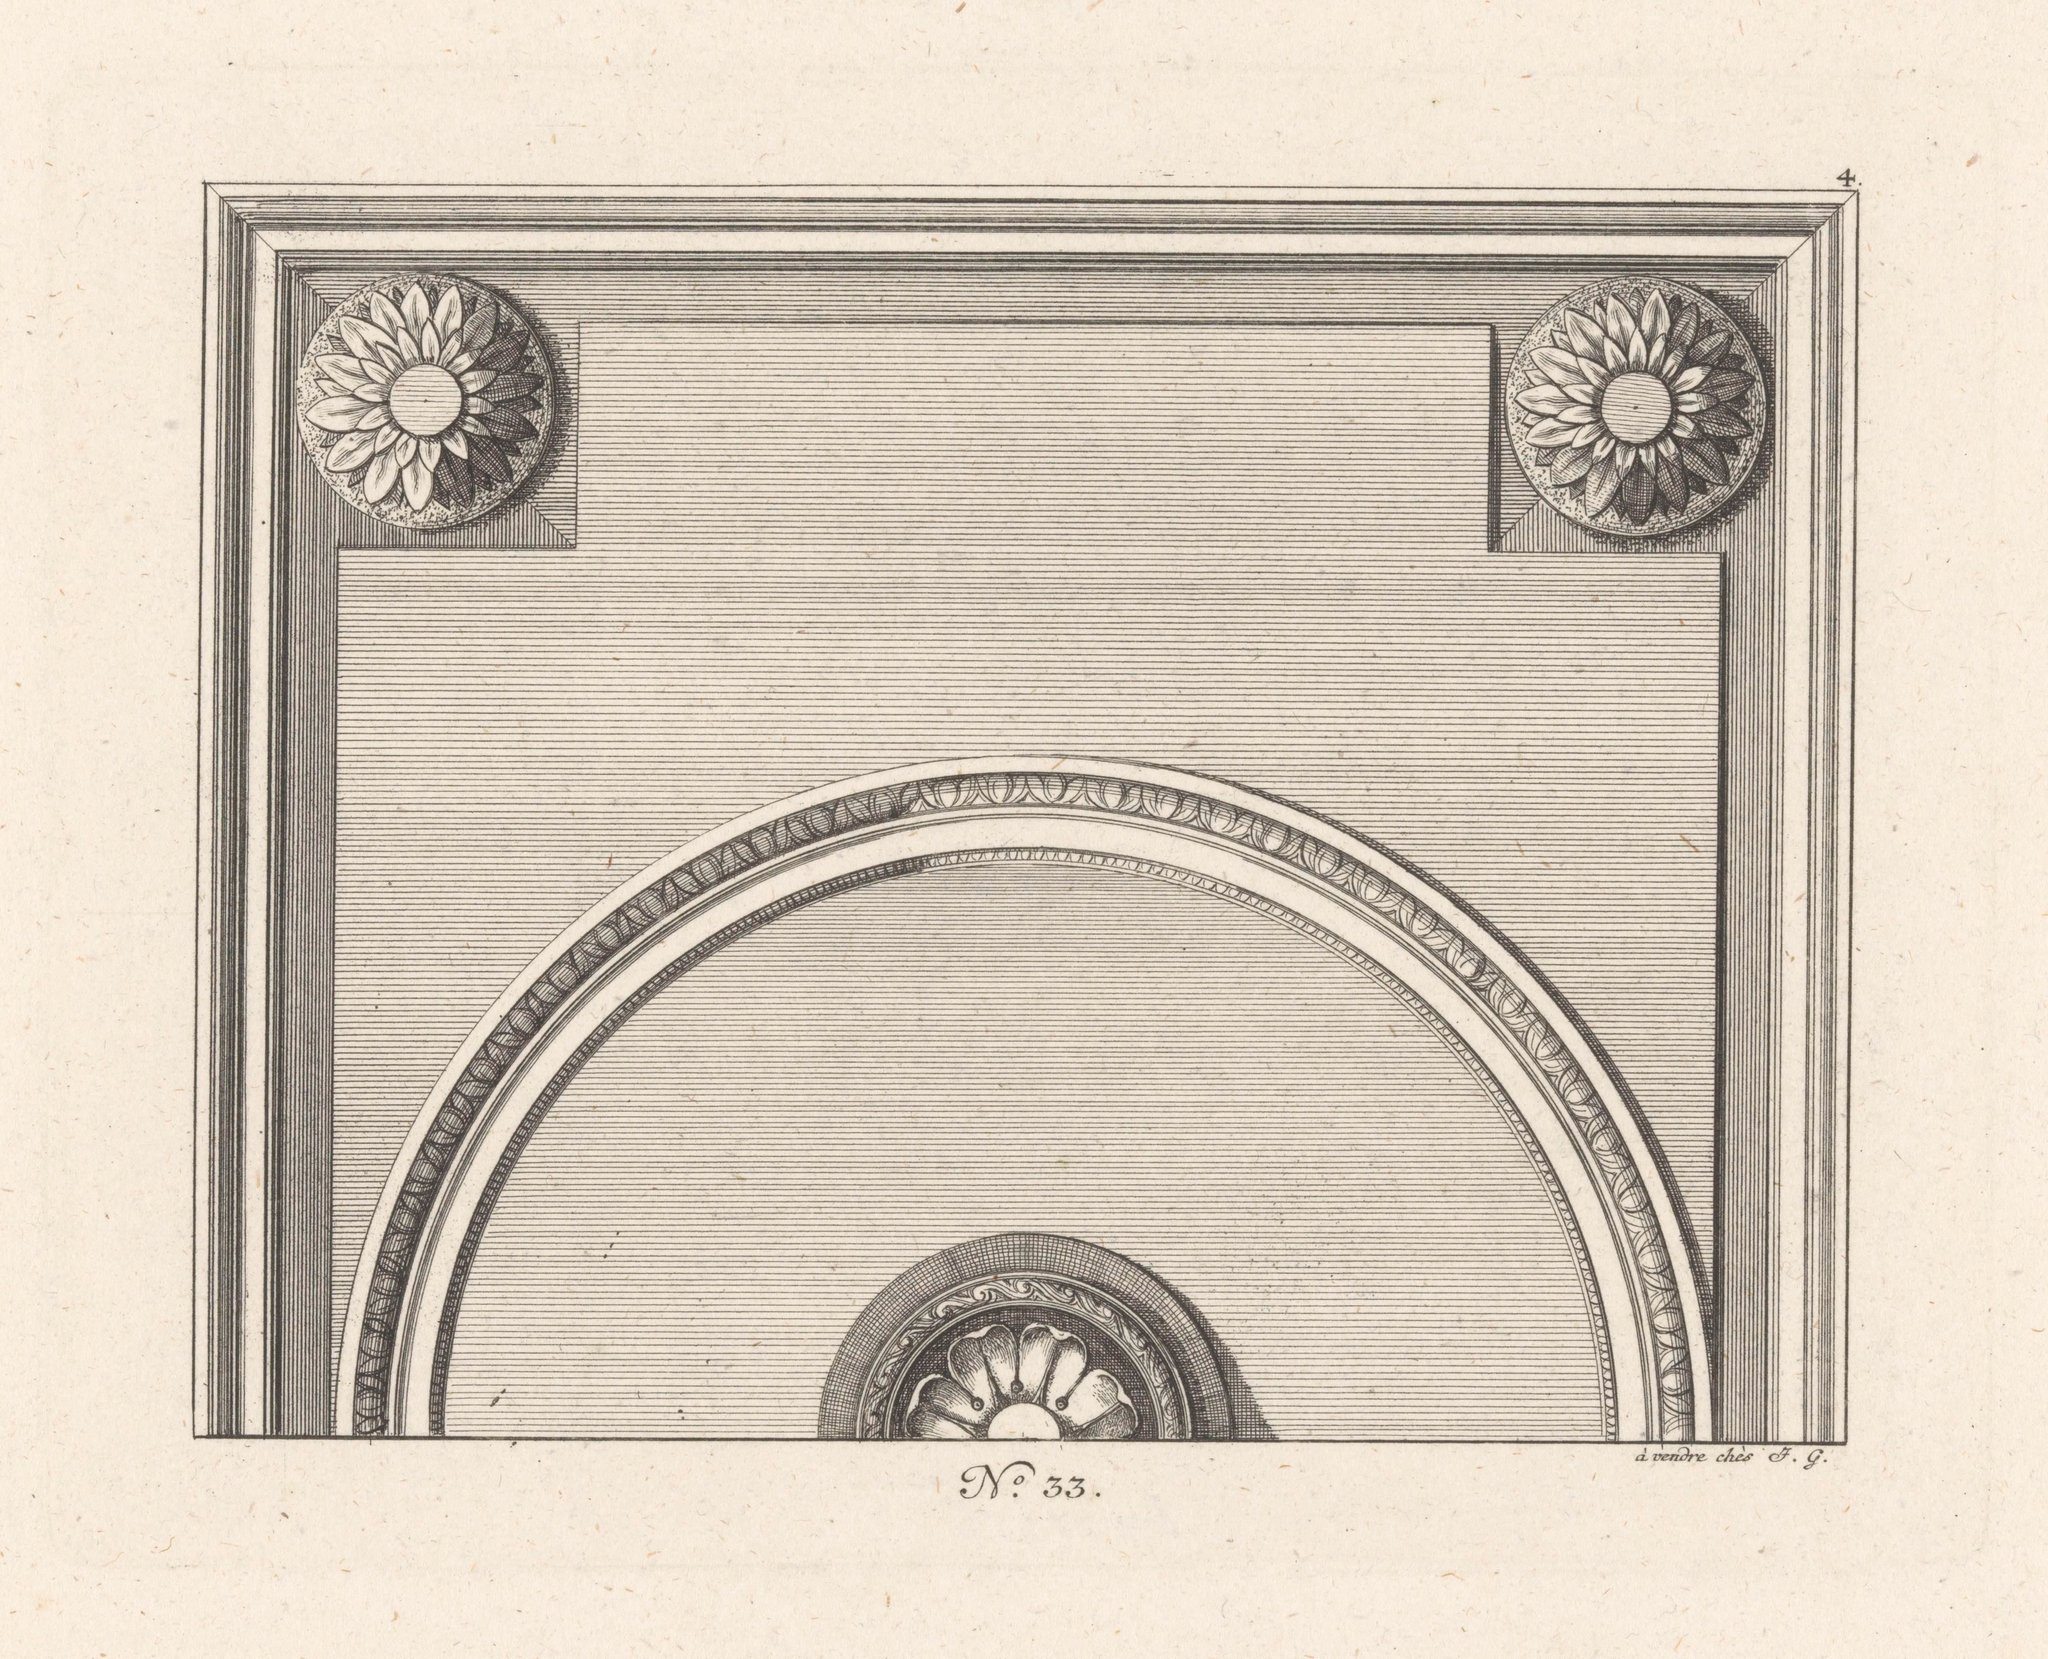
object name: ornament print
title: Plafond met bloemmotieven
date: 1758-1820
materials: paper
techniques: engraving, etching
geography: ravensburg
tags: (decorated) ceiling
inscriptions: collector's mark: 2760, collector's mark: Lugt 2228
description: Ontwerp voor een plafond met ornamenten en bloemmotieven in het midden en in de hoeken. Uitgeversnummer 33.